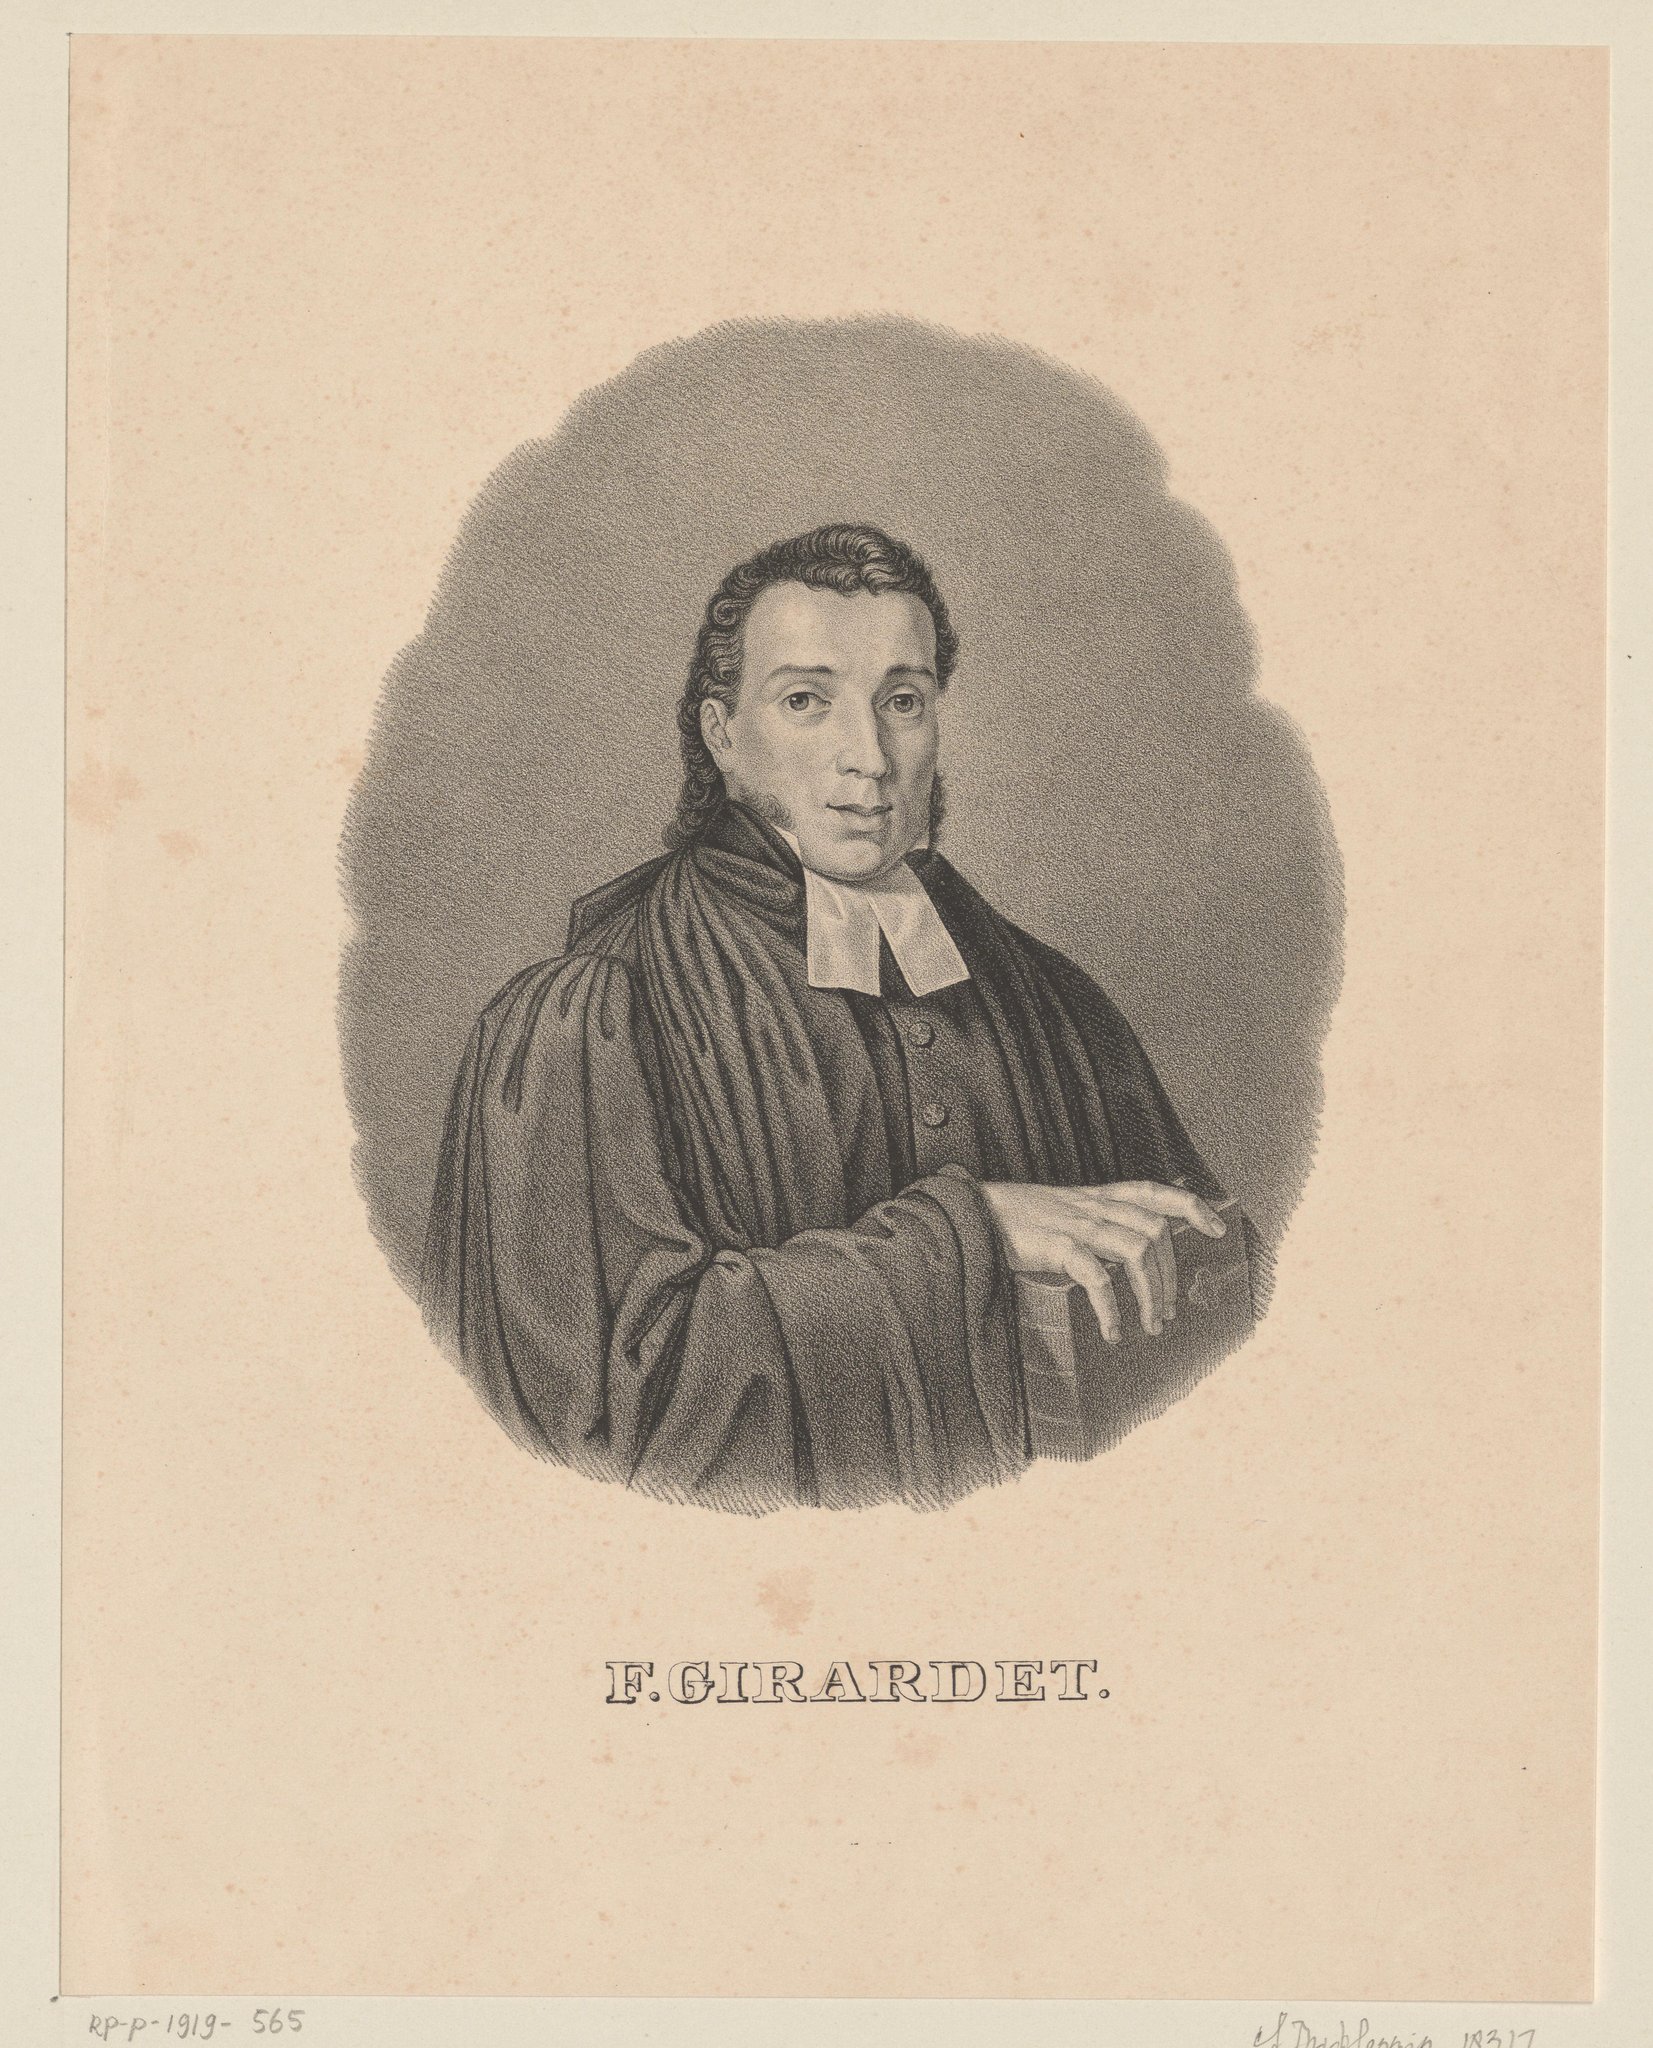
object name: print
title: Portret van Friedrich Christlieb Girardet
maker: Anonymous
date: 1800-1860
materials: paper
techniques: lithograph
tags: clergyman, theologian, historical persons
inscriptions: collector's mark: Lugt 2228